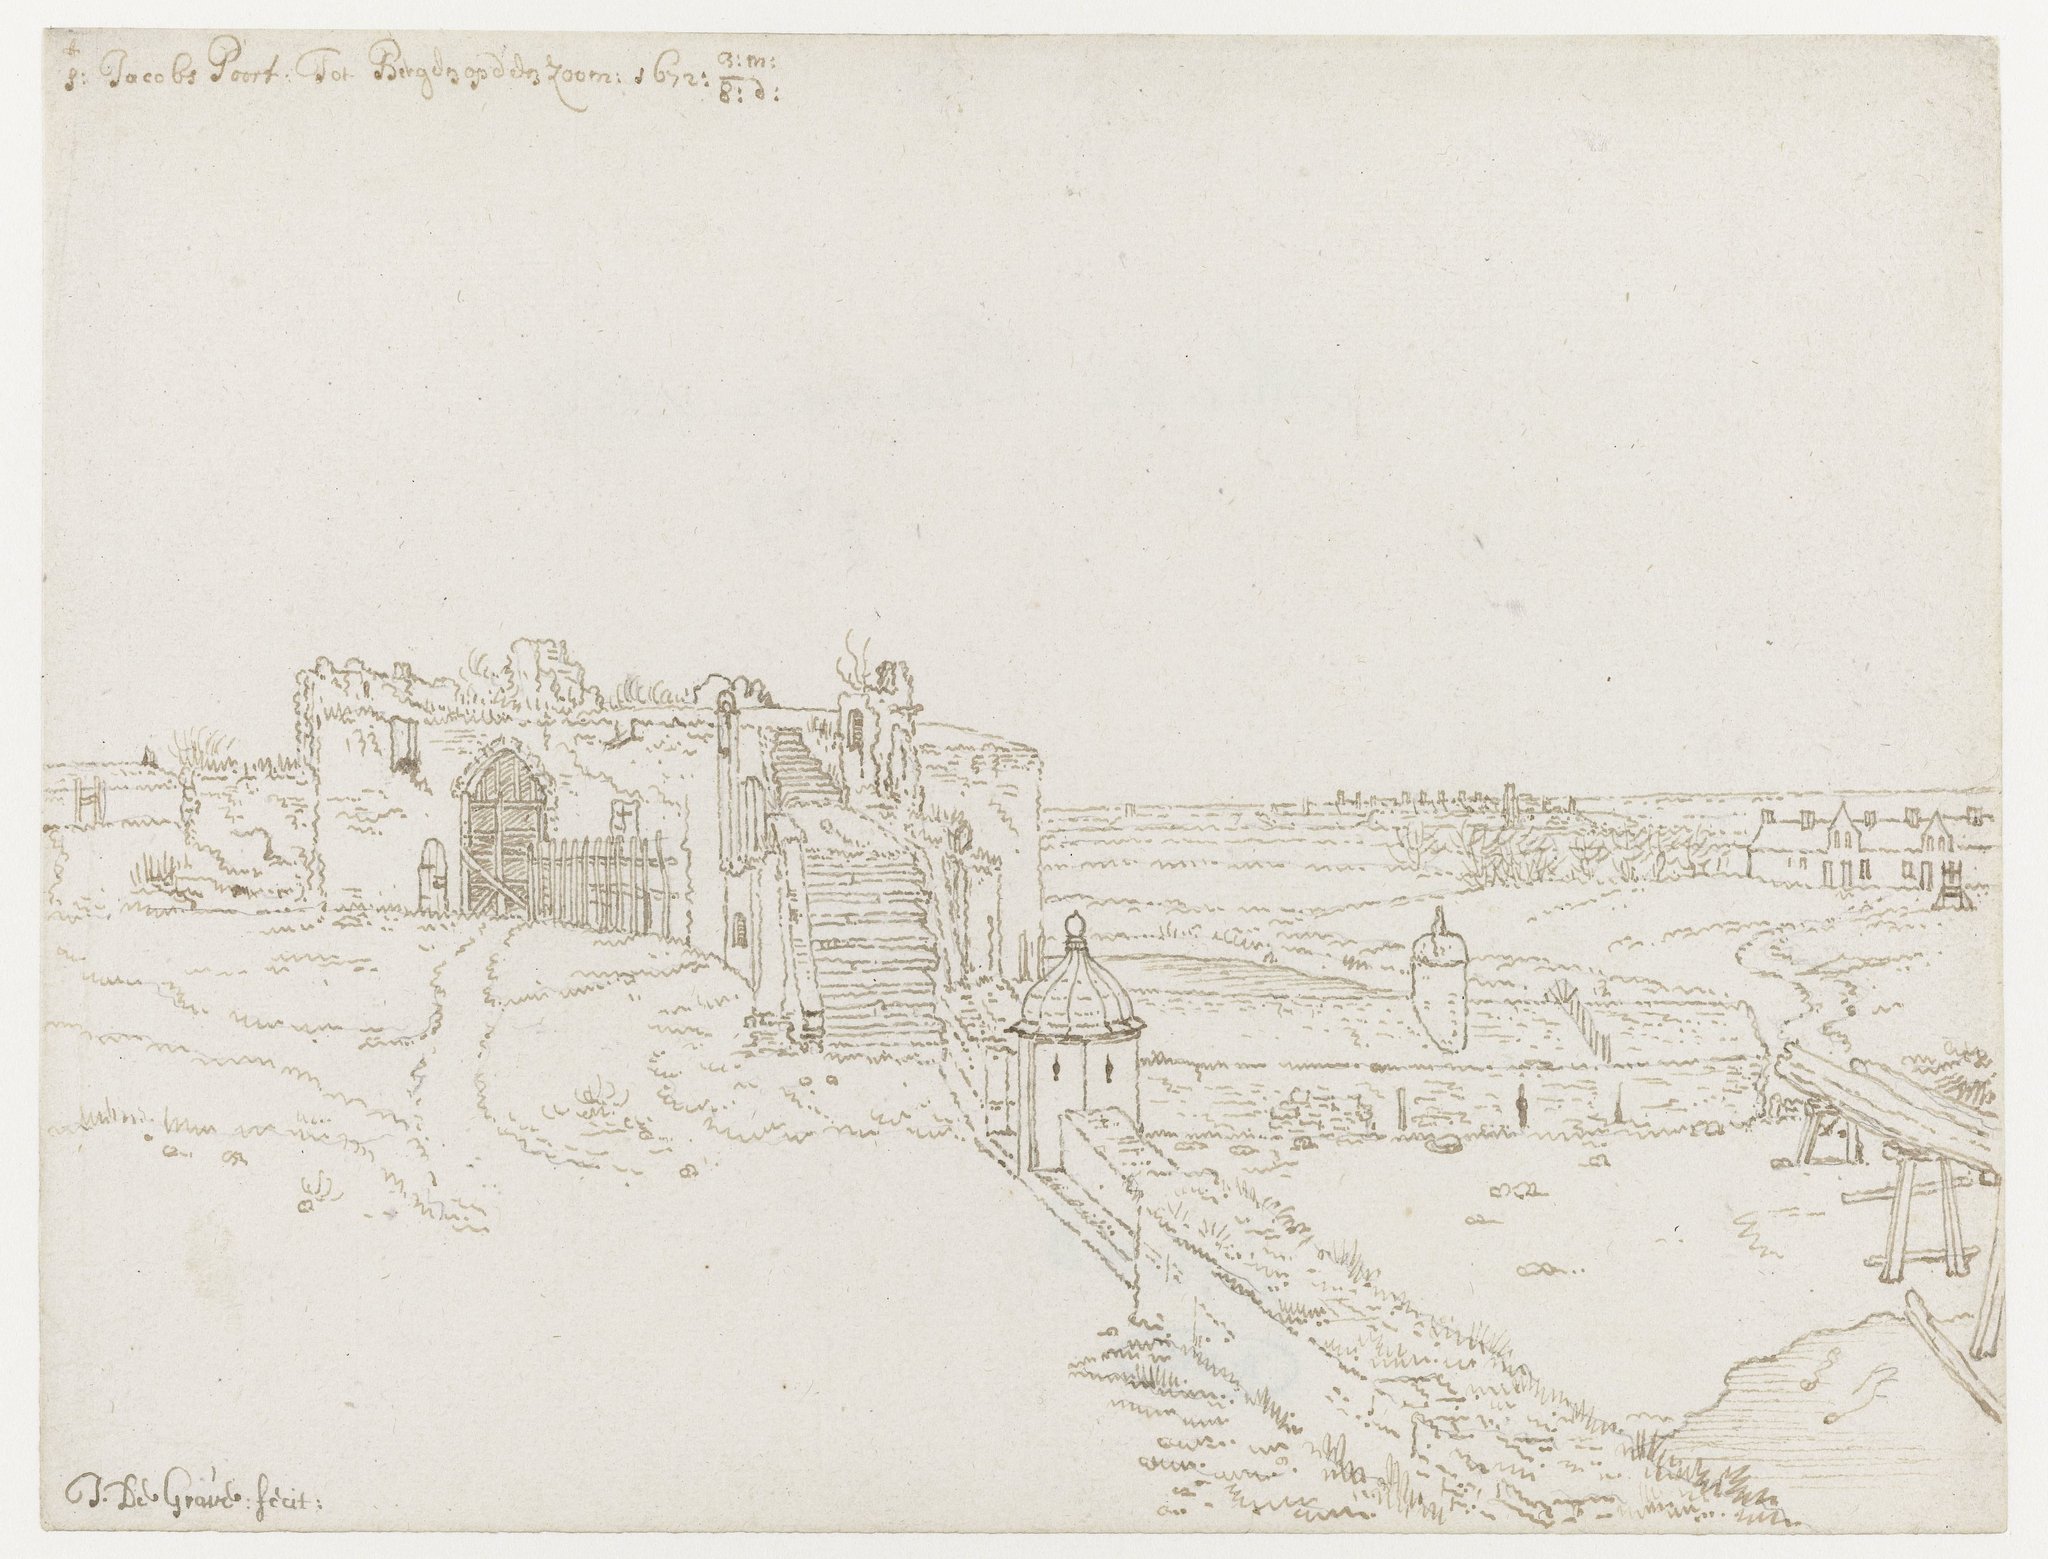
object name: drawing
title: View of the Ruins of the Sint Jacobspoort (‘St Jacob’s Gate’), Bergen op Zoom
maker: josua de grave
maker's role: draughtsman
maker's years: 1645-1712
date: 1672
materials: graphite, ink, paper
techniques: pen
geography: bergen op zoom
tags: ruin of a building ~ architecture, city-gate, bergen op zoom